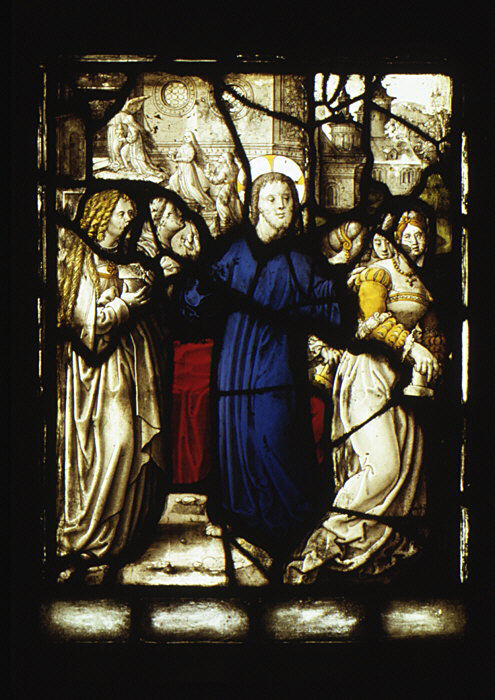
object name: panel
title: The Parable of the Wise and Foolish Virgins (one of a set of 12 scenes from The Life of Christ)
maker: jan rombouts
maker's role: maker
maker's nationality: south netherlandish (duchy of brabant)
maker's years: 1475-1535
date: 1525-1530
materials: glass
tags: women,christ